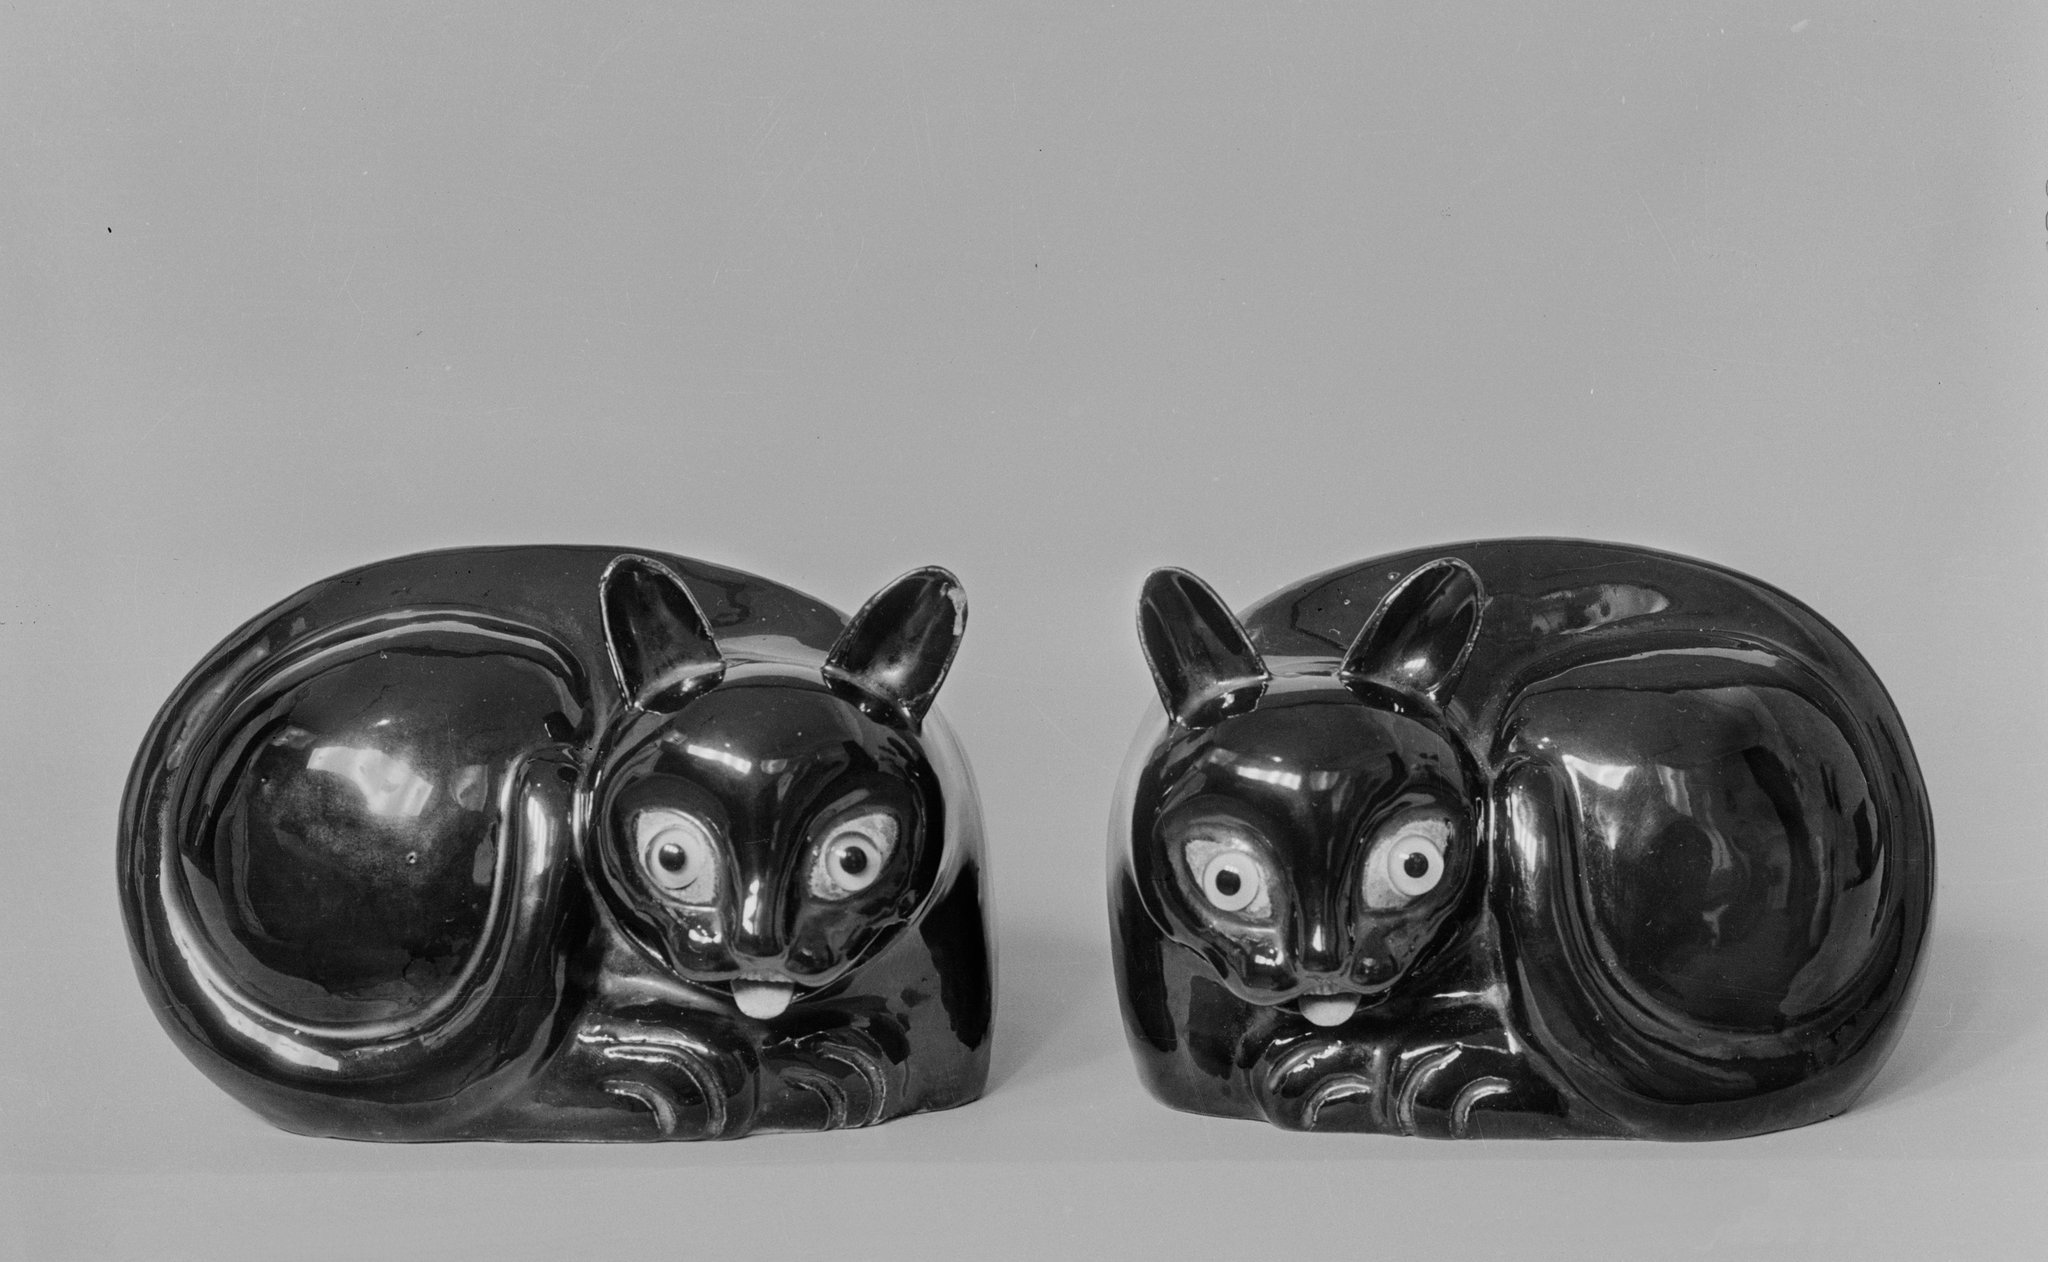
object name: cat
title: Cat (one of a pair)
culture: chinese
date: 1701-1800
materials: enamel, plastic, porcelain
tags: cats